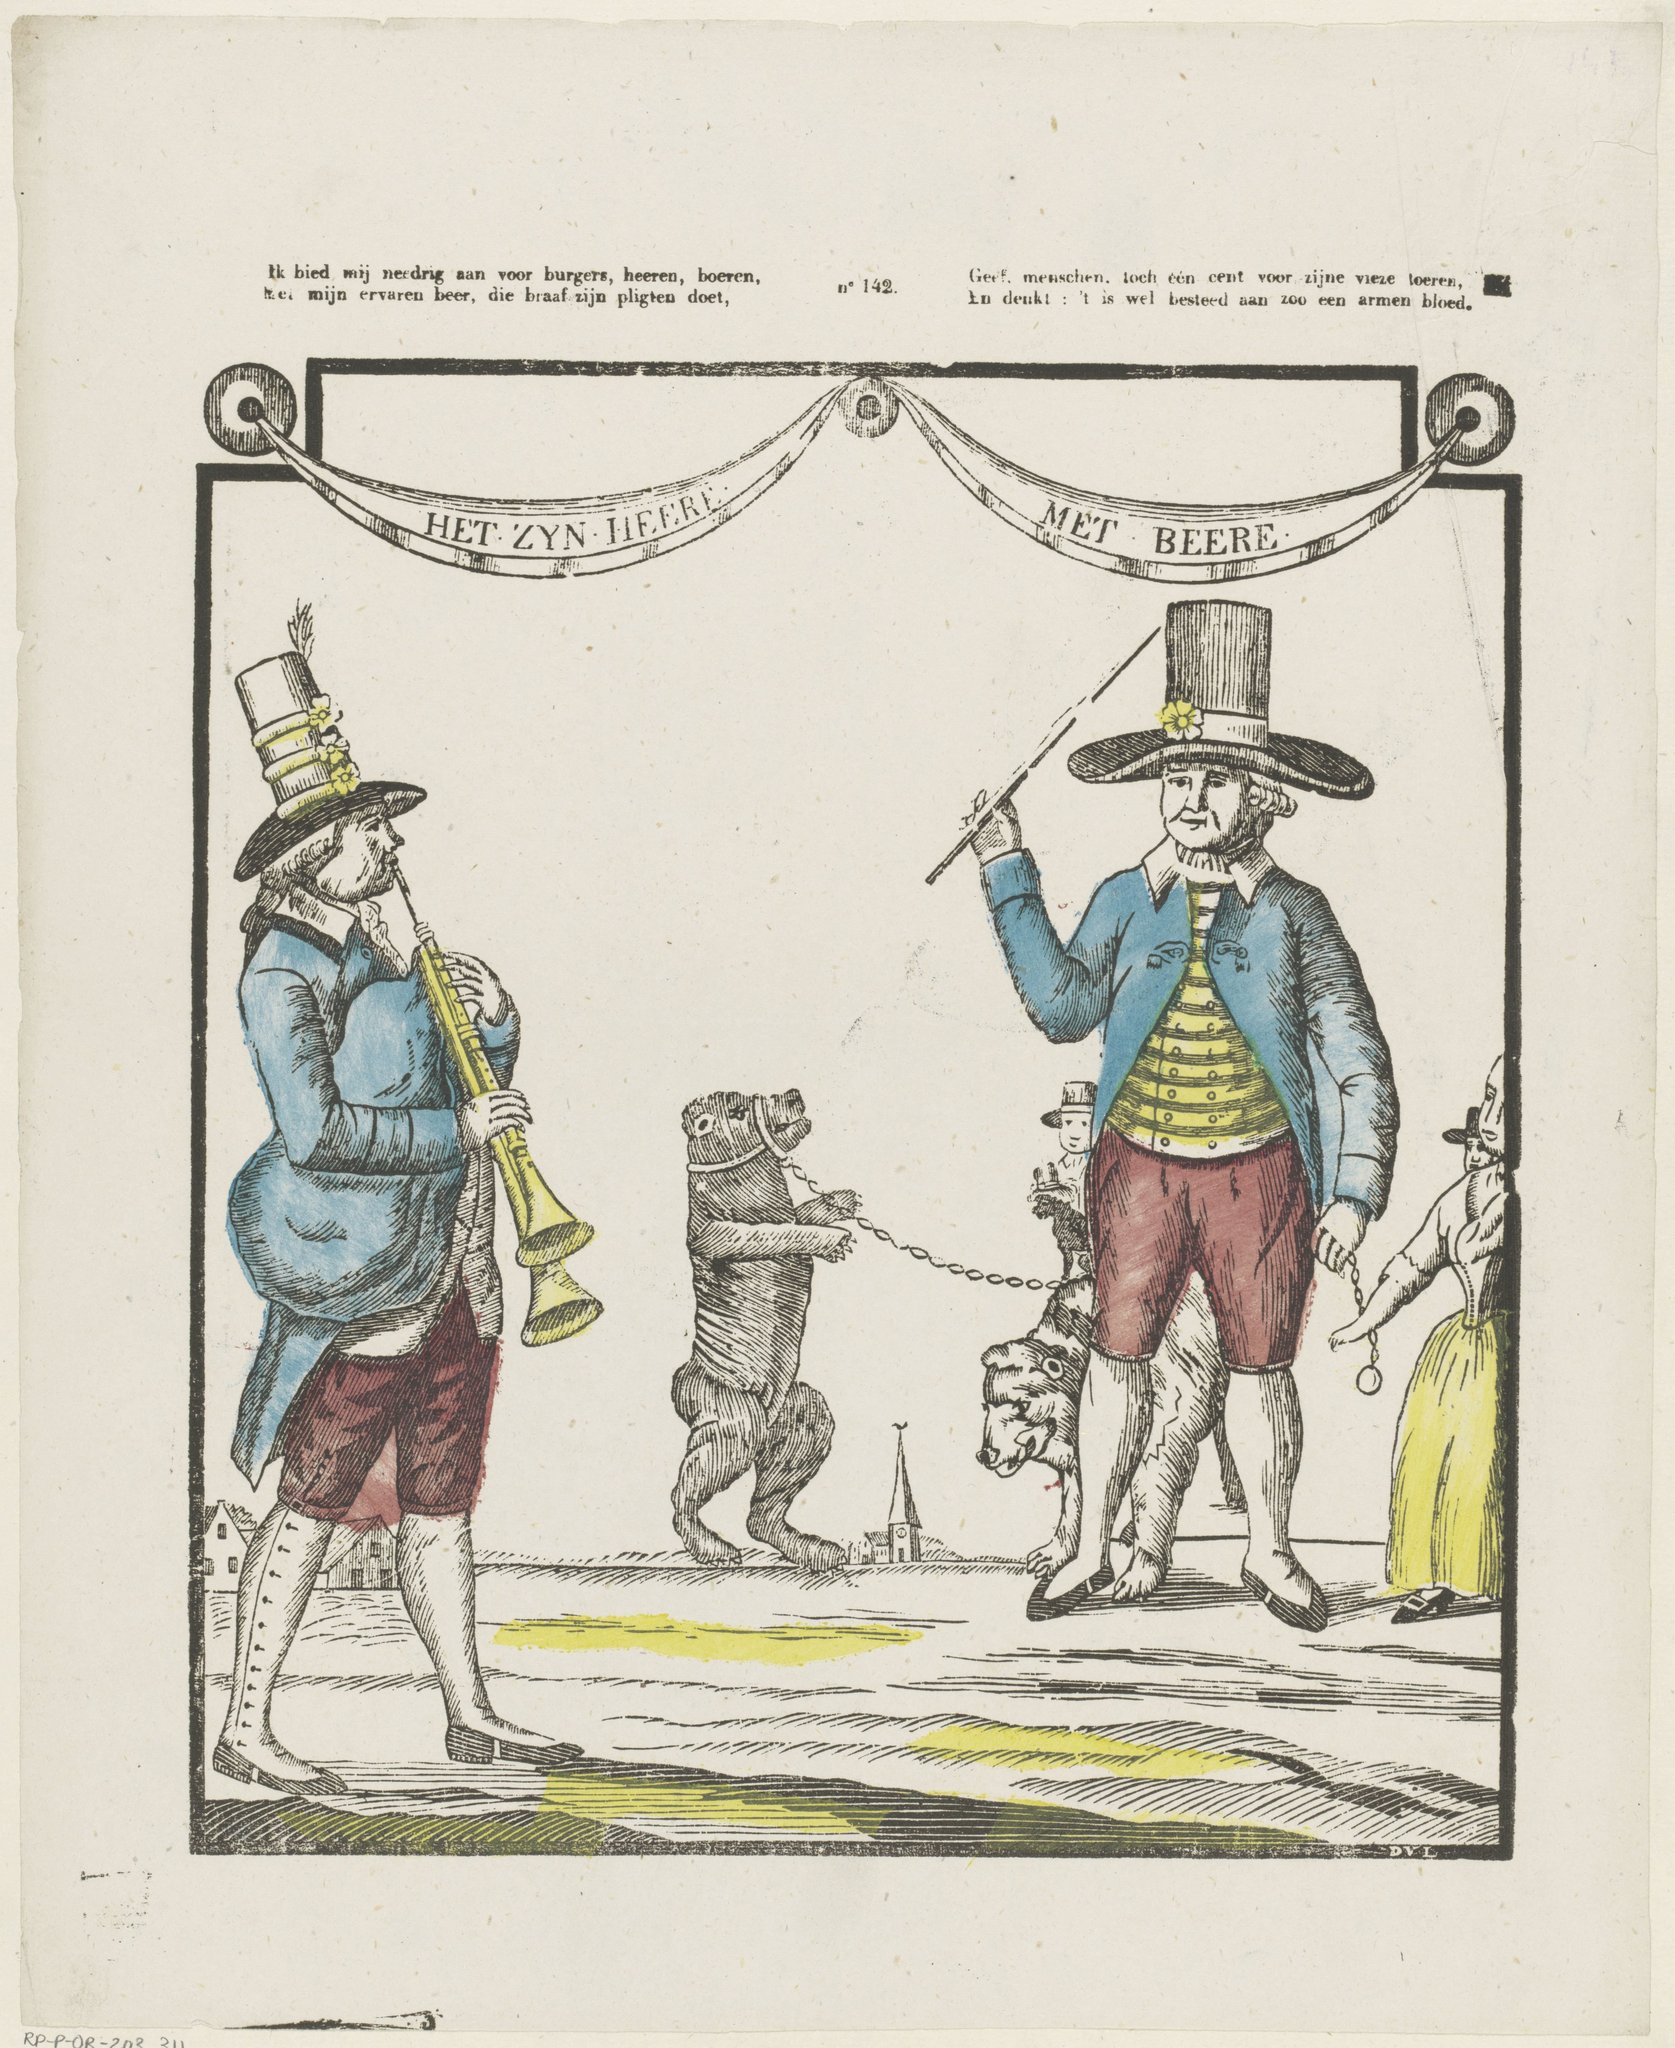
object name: popular print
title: Het zyn heere / met beere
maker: dirk van lubeek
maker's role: print maker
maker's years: 1747-1811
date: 1833-1900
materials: paper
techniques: colour, letterpress printing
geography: rotterdam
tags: taming and training of animals, bears (circus performance) (+ dancing ~ festive activities), bagpipe, musette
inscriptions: collector's mark: Lugt 2760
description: Blad met een grote voorstelling van twee mannen met twee dansende beren. Één van de mannen speelt doedelzak. Genummerd midden boven: no. 142.